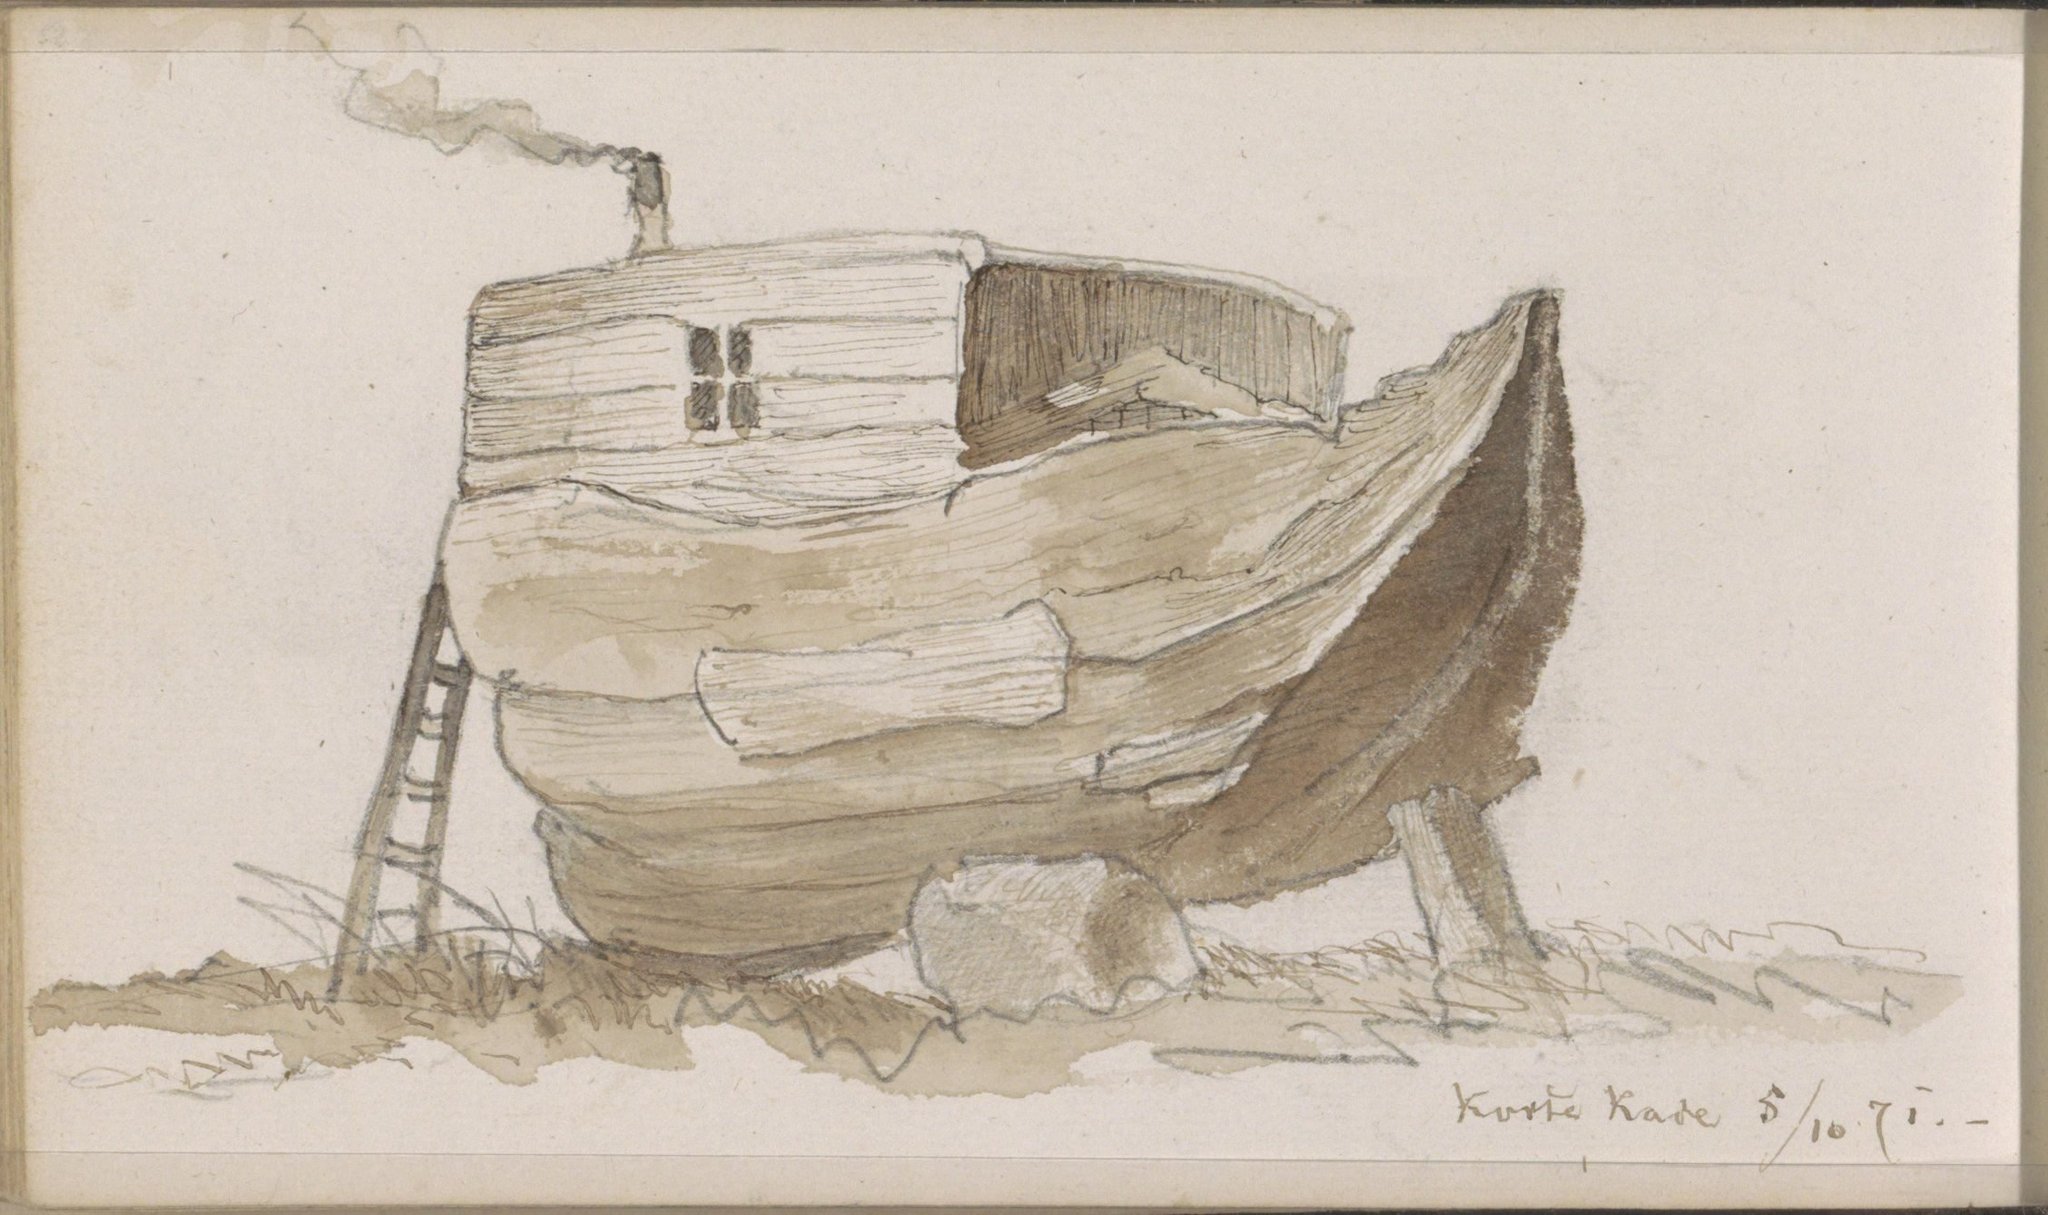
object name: sketchbook leaf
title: Stoomschuit aan de Kortekade in Rotterdam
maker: johannes tavenraat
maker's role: draughtsman, painter, print maker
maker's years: 1809-1881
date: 1810-1871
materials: ink, paper, pencil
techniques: brush, pen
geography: rotterdam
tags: boat propelled by man or animal (+ propulsion of vehicle, ship, etc. by steam), rotterdam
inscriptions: date and inscription: ‘Korte Kade 5/10 71.’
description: Blad 83 verso uit een schetsboek met 98 bladen.